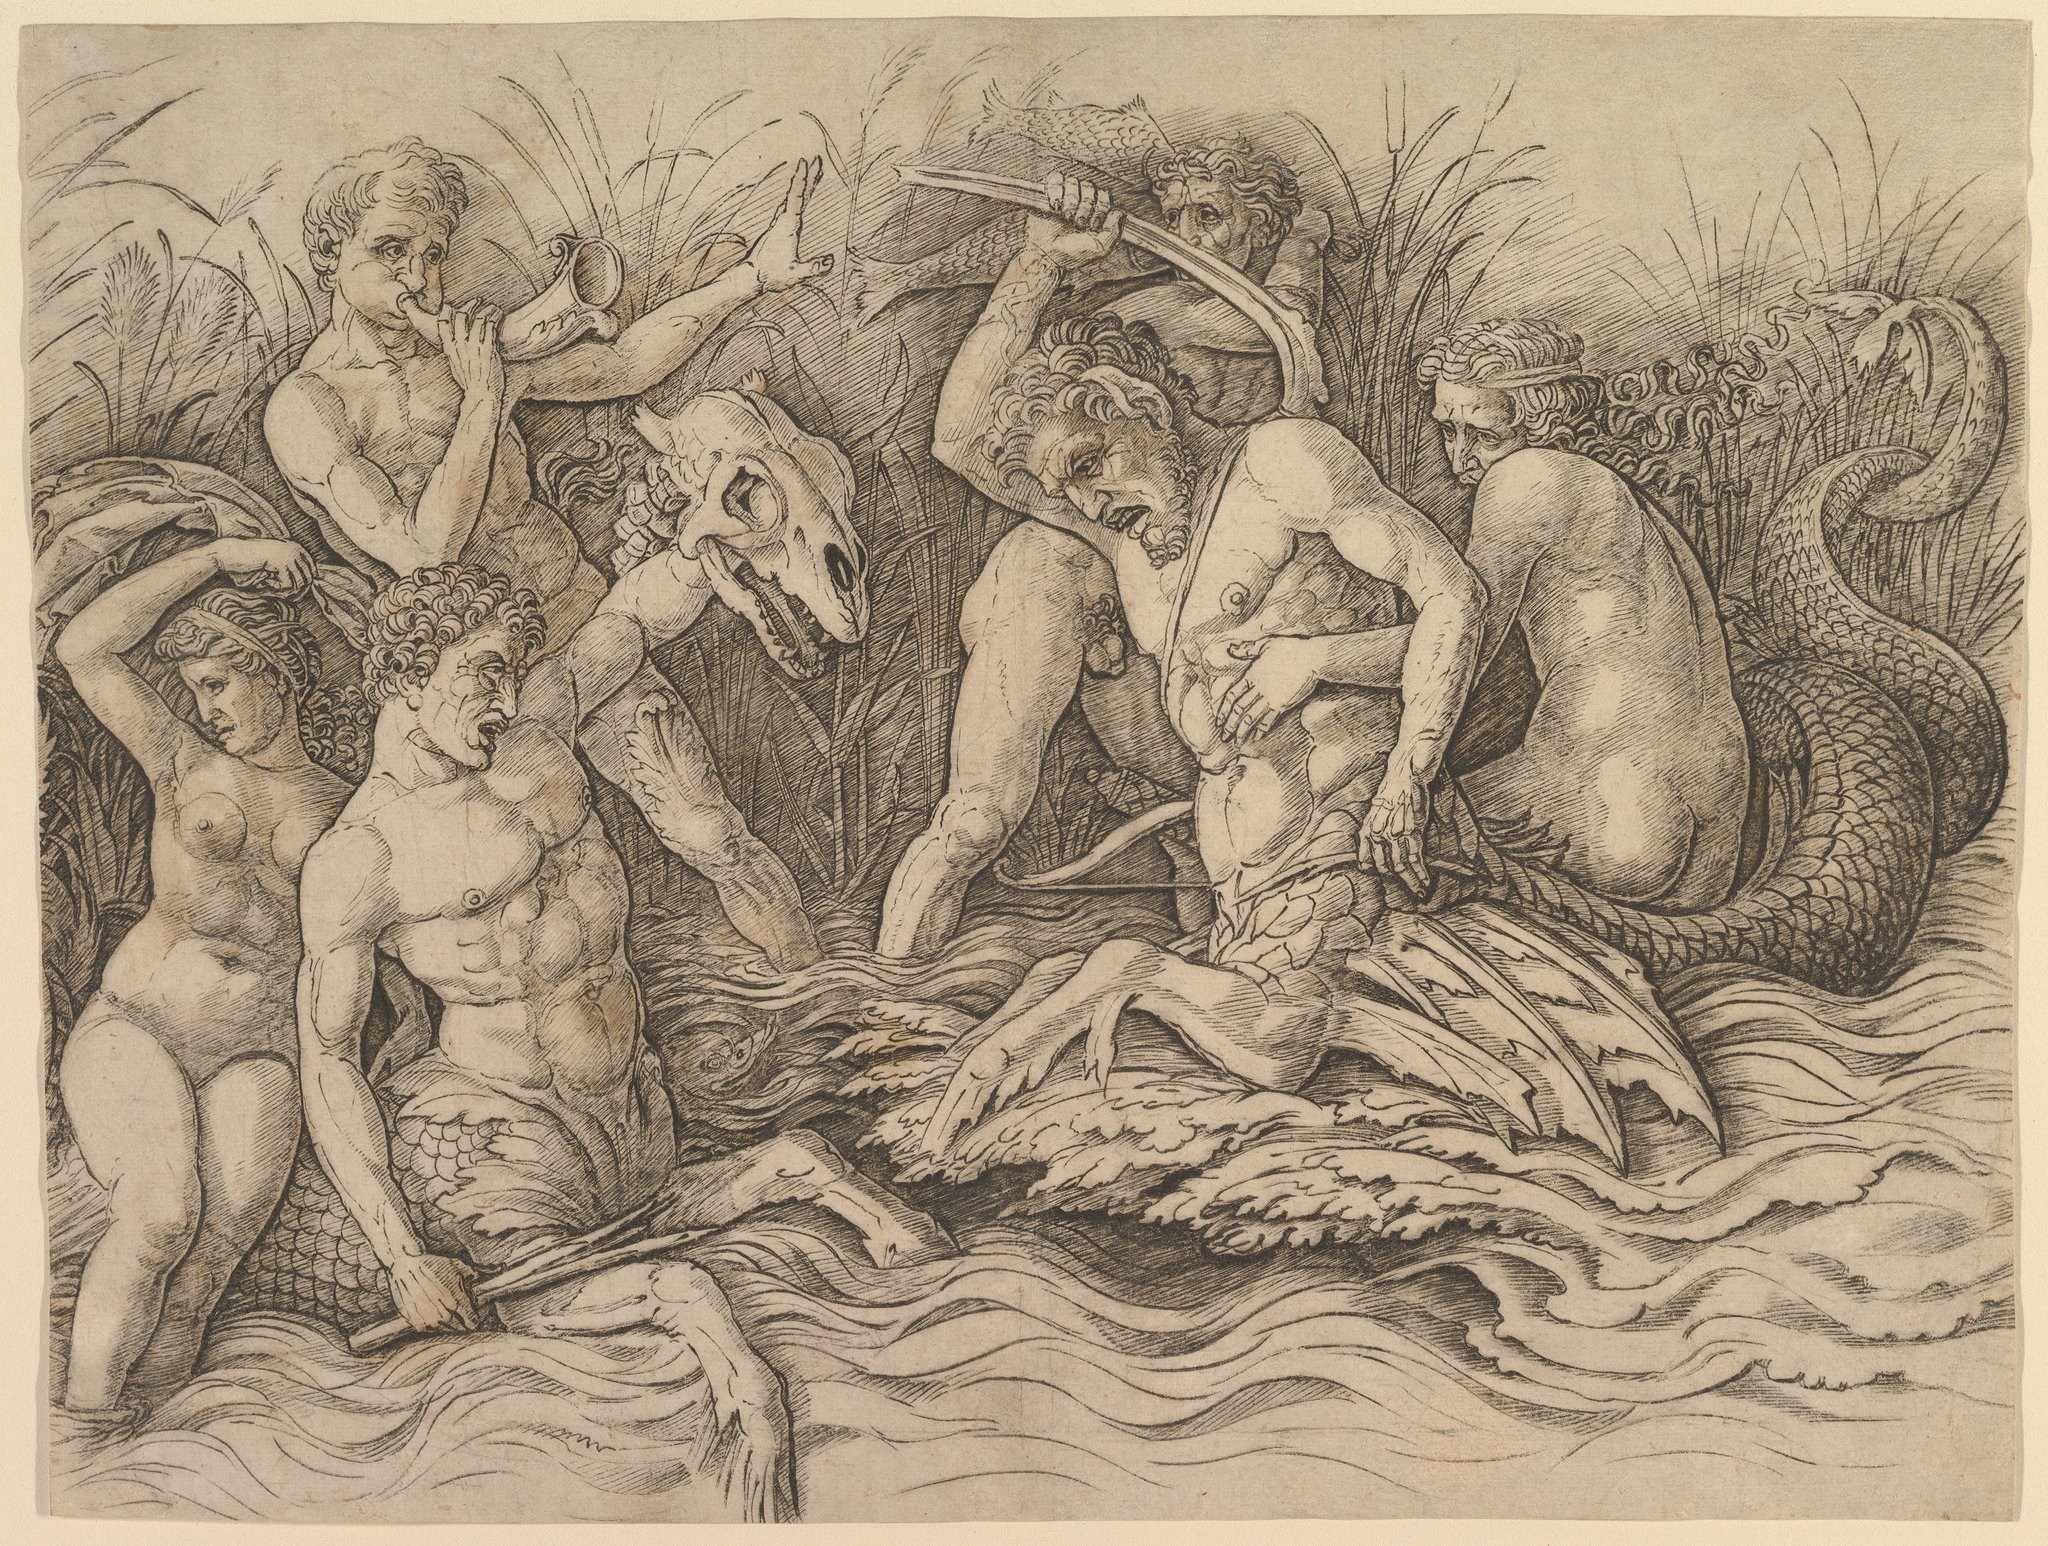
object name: print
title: Battle of the Sea Gods (right portion of frieze)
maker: andrea mantegna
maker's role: artist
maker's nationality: italian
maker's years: 1431-1506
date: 1481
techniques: engraving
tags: battles,female nudes,mythical creatures